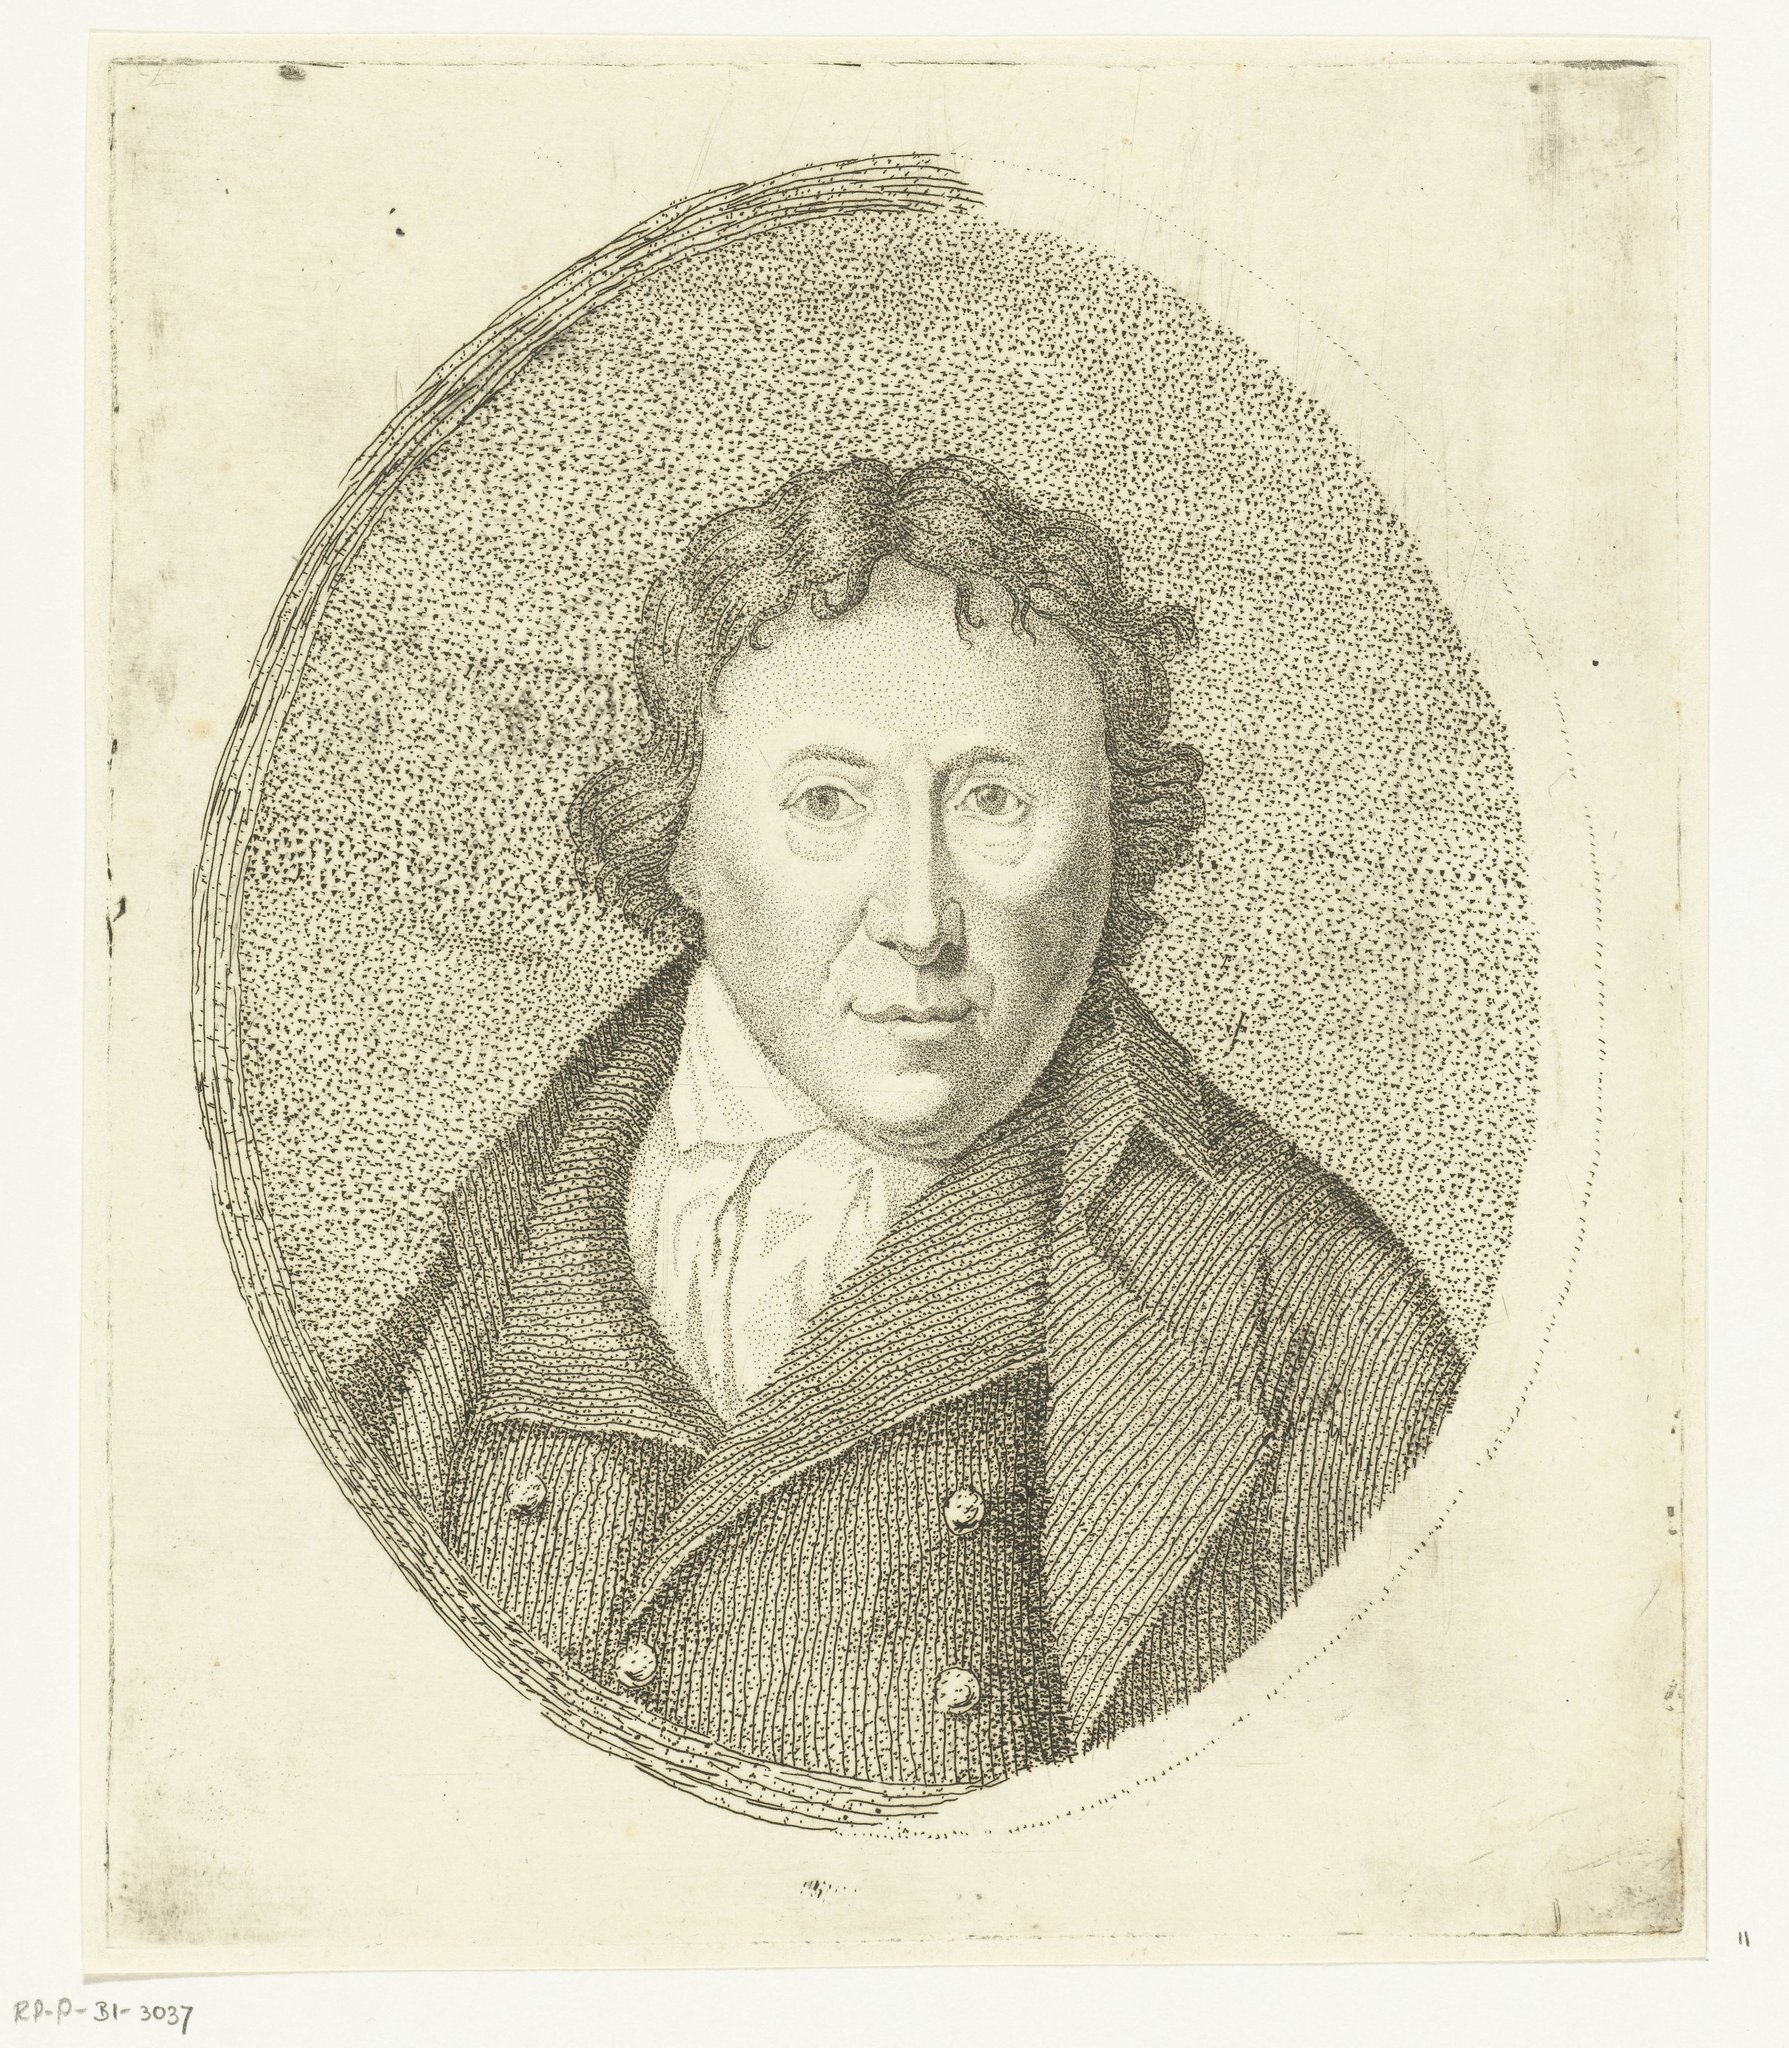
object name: print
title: Portret van Gerard van Nijmegen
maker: anthonie van den bos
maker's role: draughtsman, print maker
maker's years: 1763-1838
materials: paper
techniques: etching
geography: netherlands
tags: rotterdam, painter, print maker, draughtsman, gerard van nijmegen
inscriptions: collector's mark: Lugt 2228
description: Borstbeeld van de Rotterdamse schilder Gerard van Nijmegen.